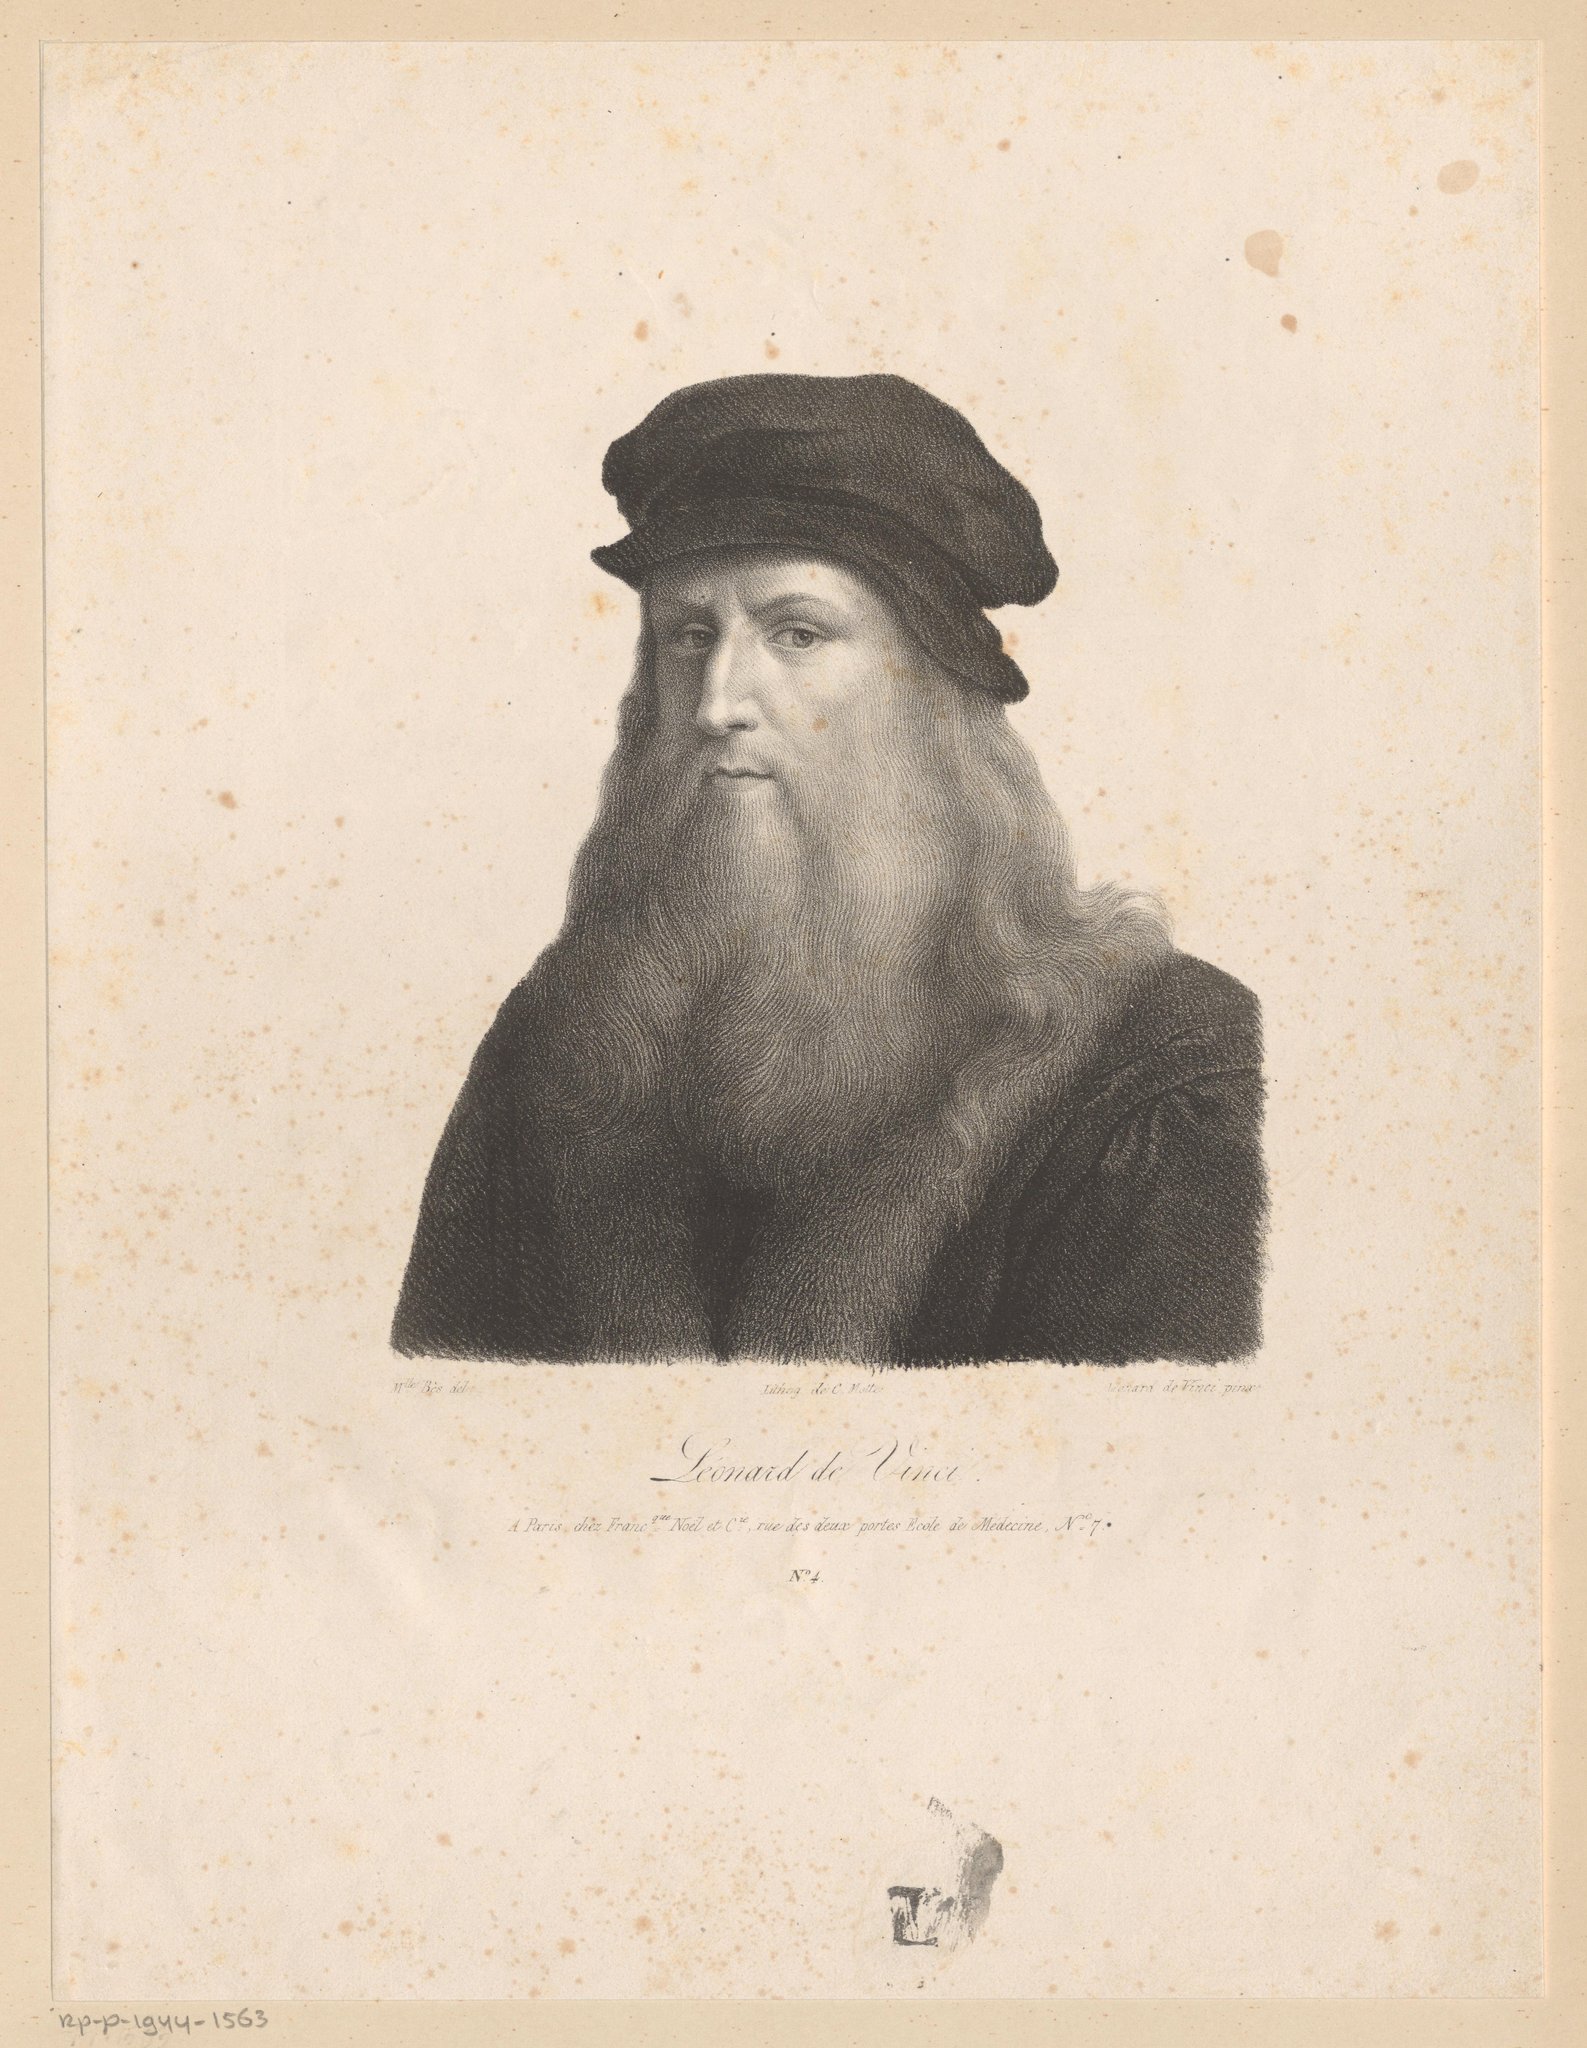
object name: print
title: Portret van Leonardo da Vinci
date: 1824-1827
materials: paper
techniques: lithograph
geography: italy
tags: artist, leonardo da vinci, historical persons, portrait, self-portrait of artist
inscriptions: collector's mark: Lugt 2228